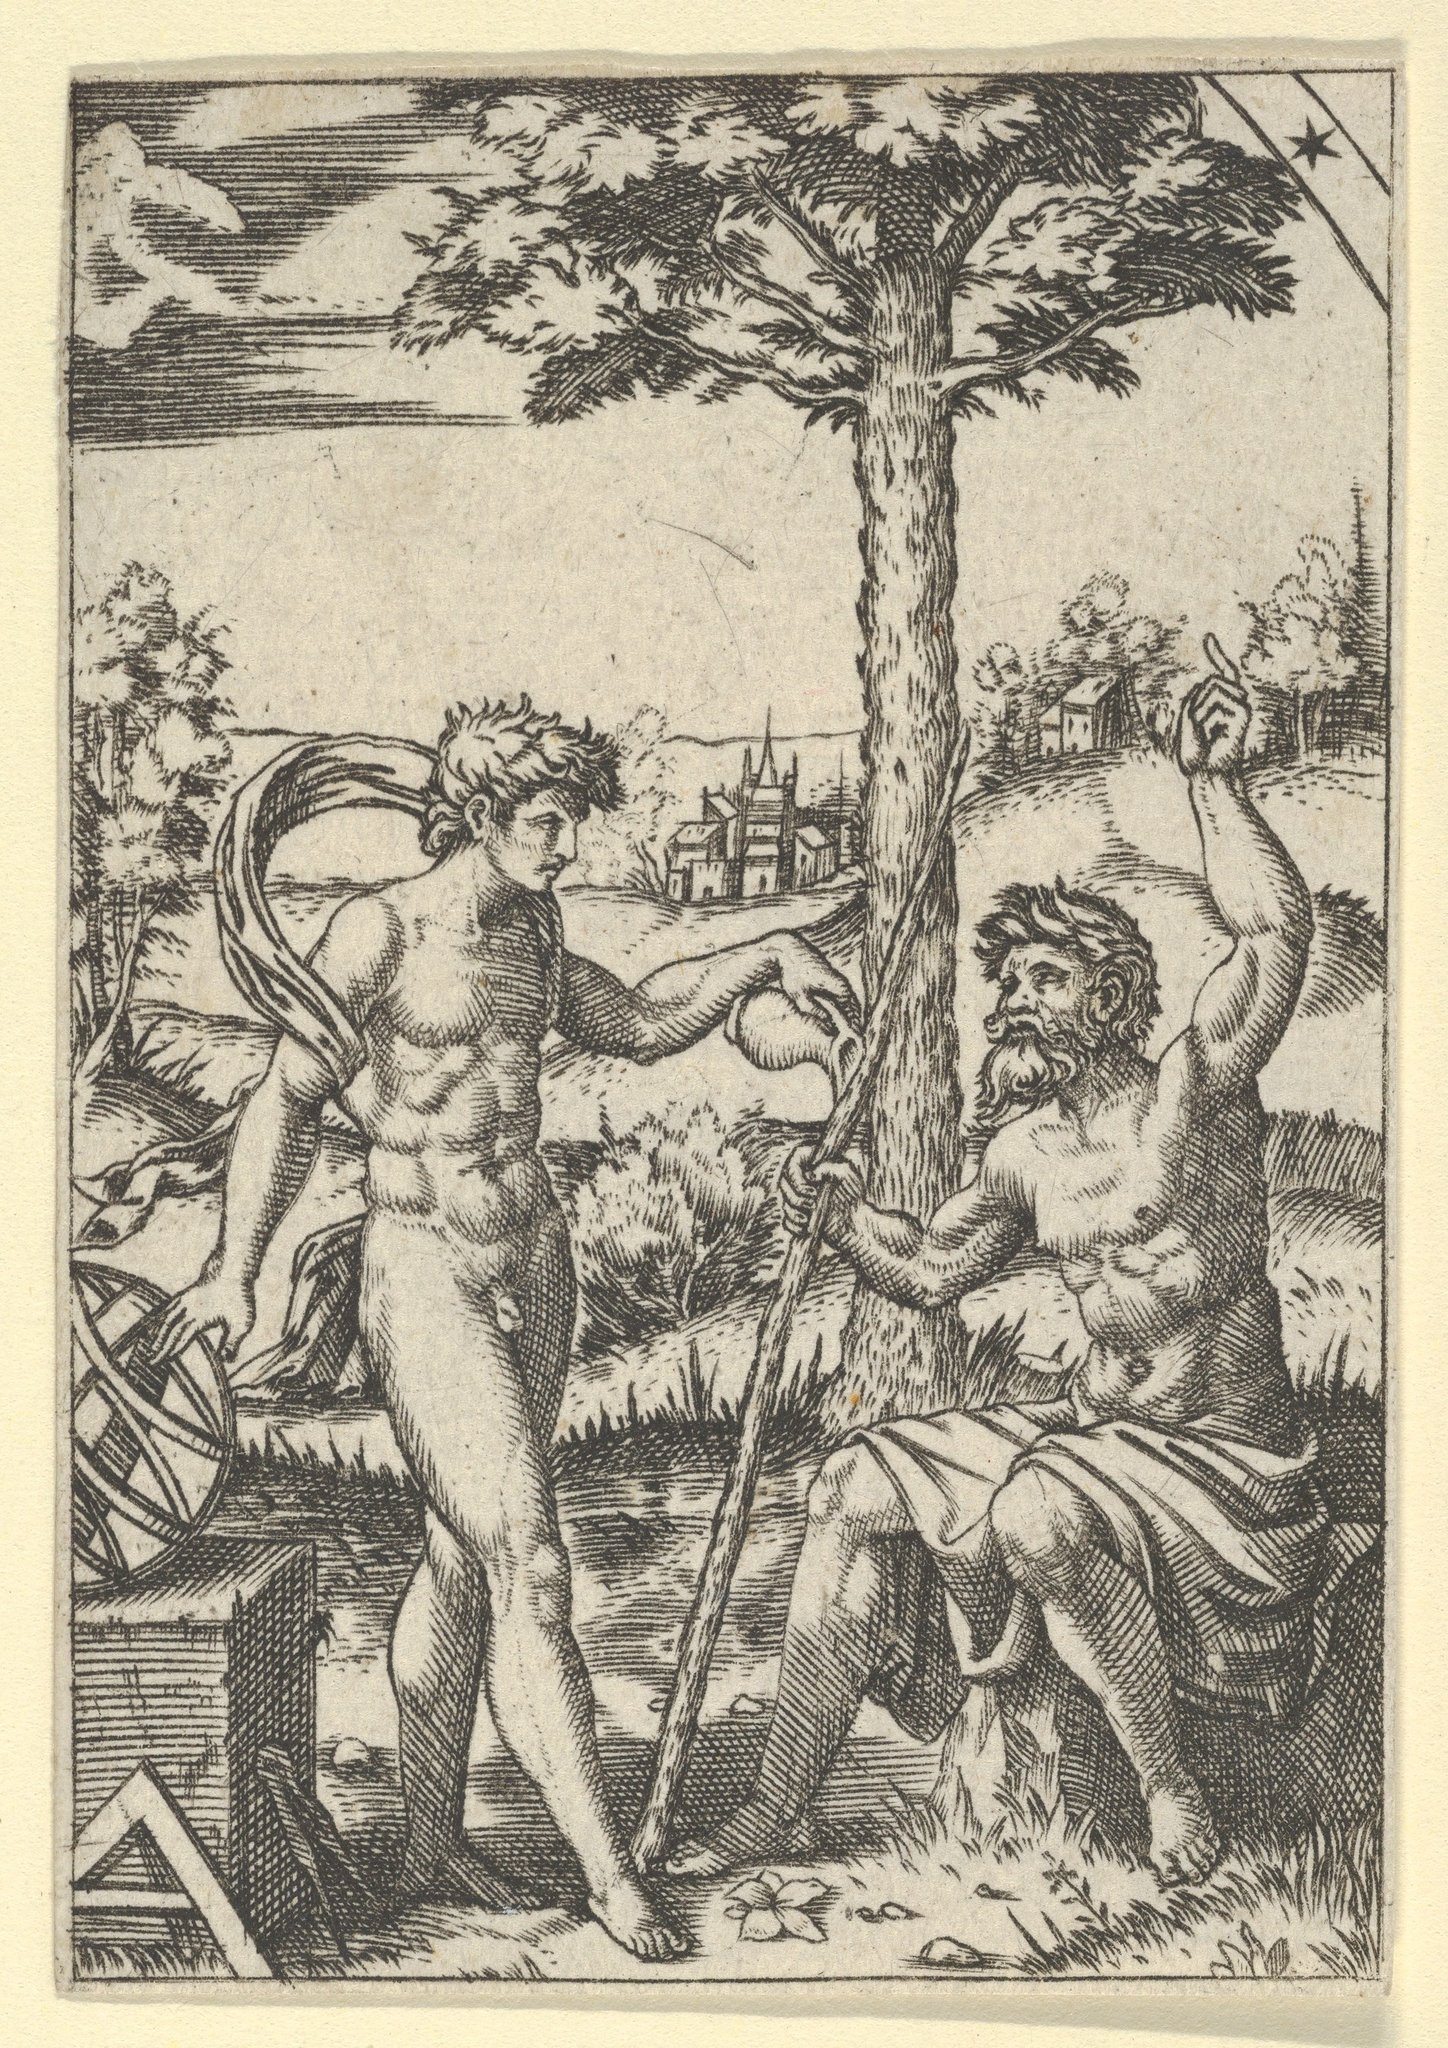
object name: print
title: Seated old shepherd gesturing towards the sky and speaking to nude male surrounded by tools of measurement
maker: Anonymous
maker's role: artist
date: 1500-1600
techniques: engraving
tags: men,male nudes,shepherds